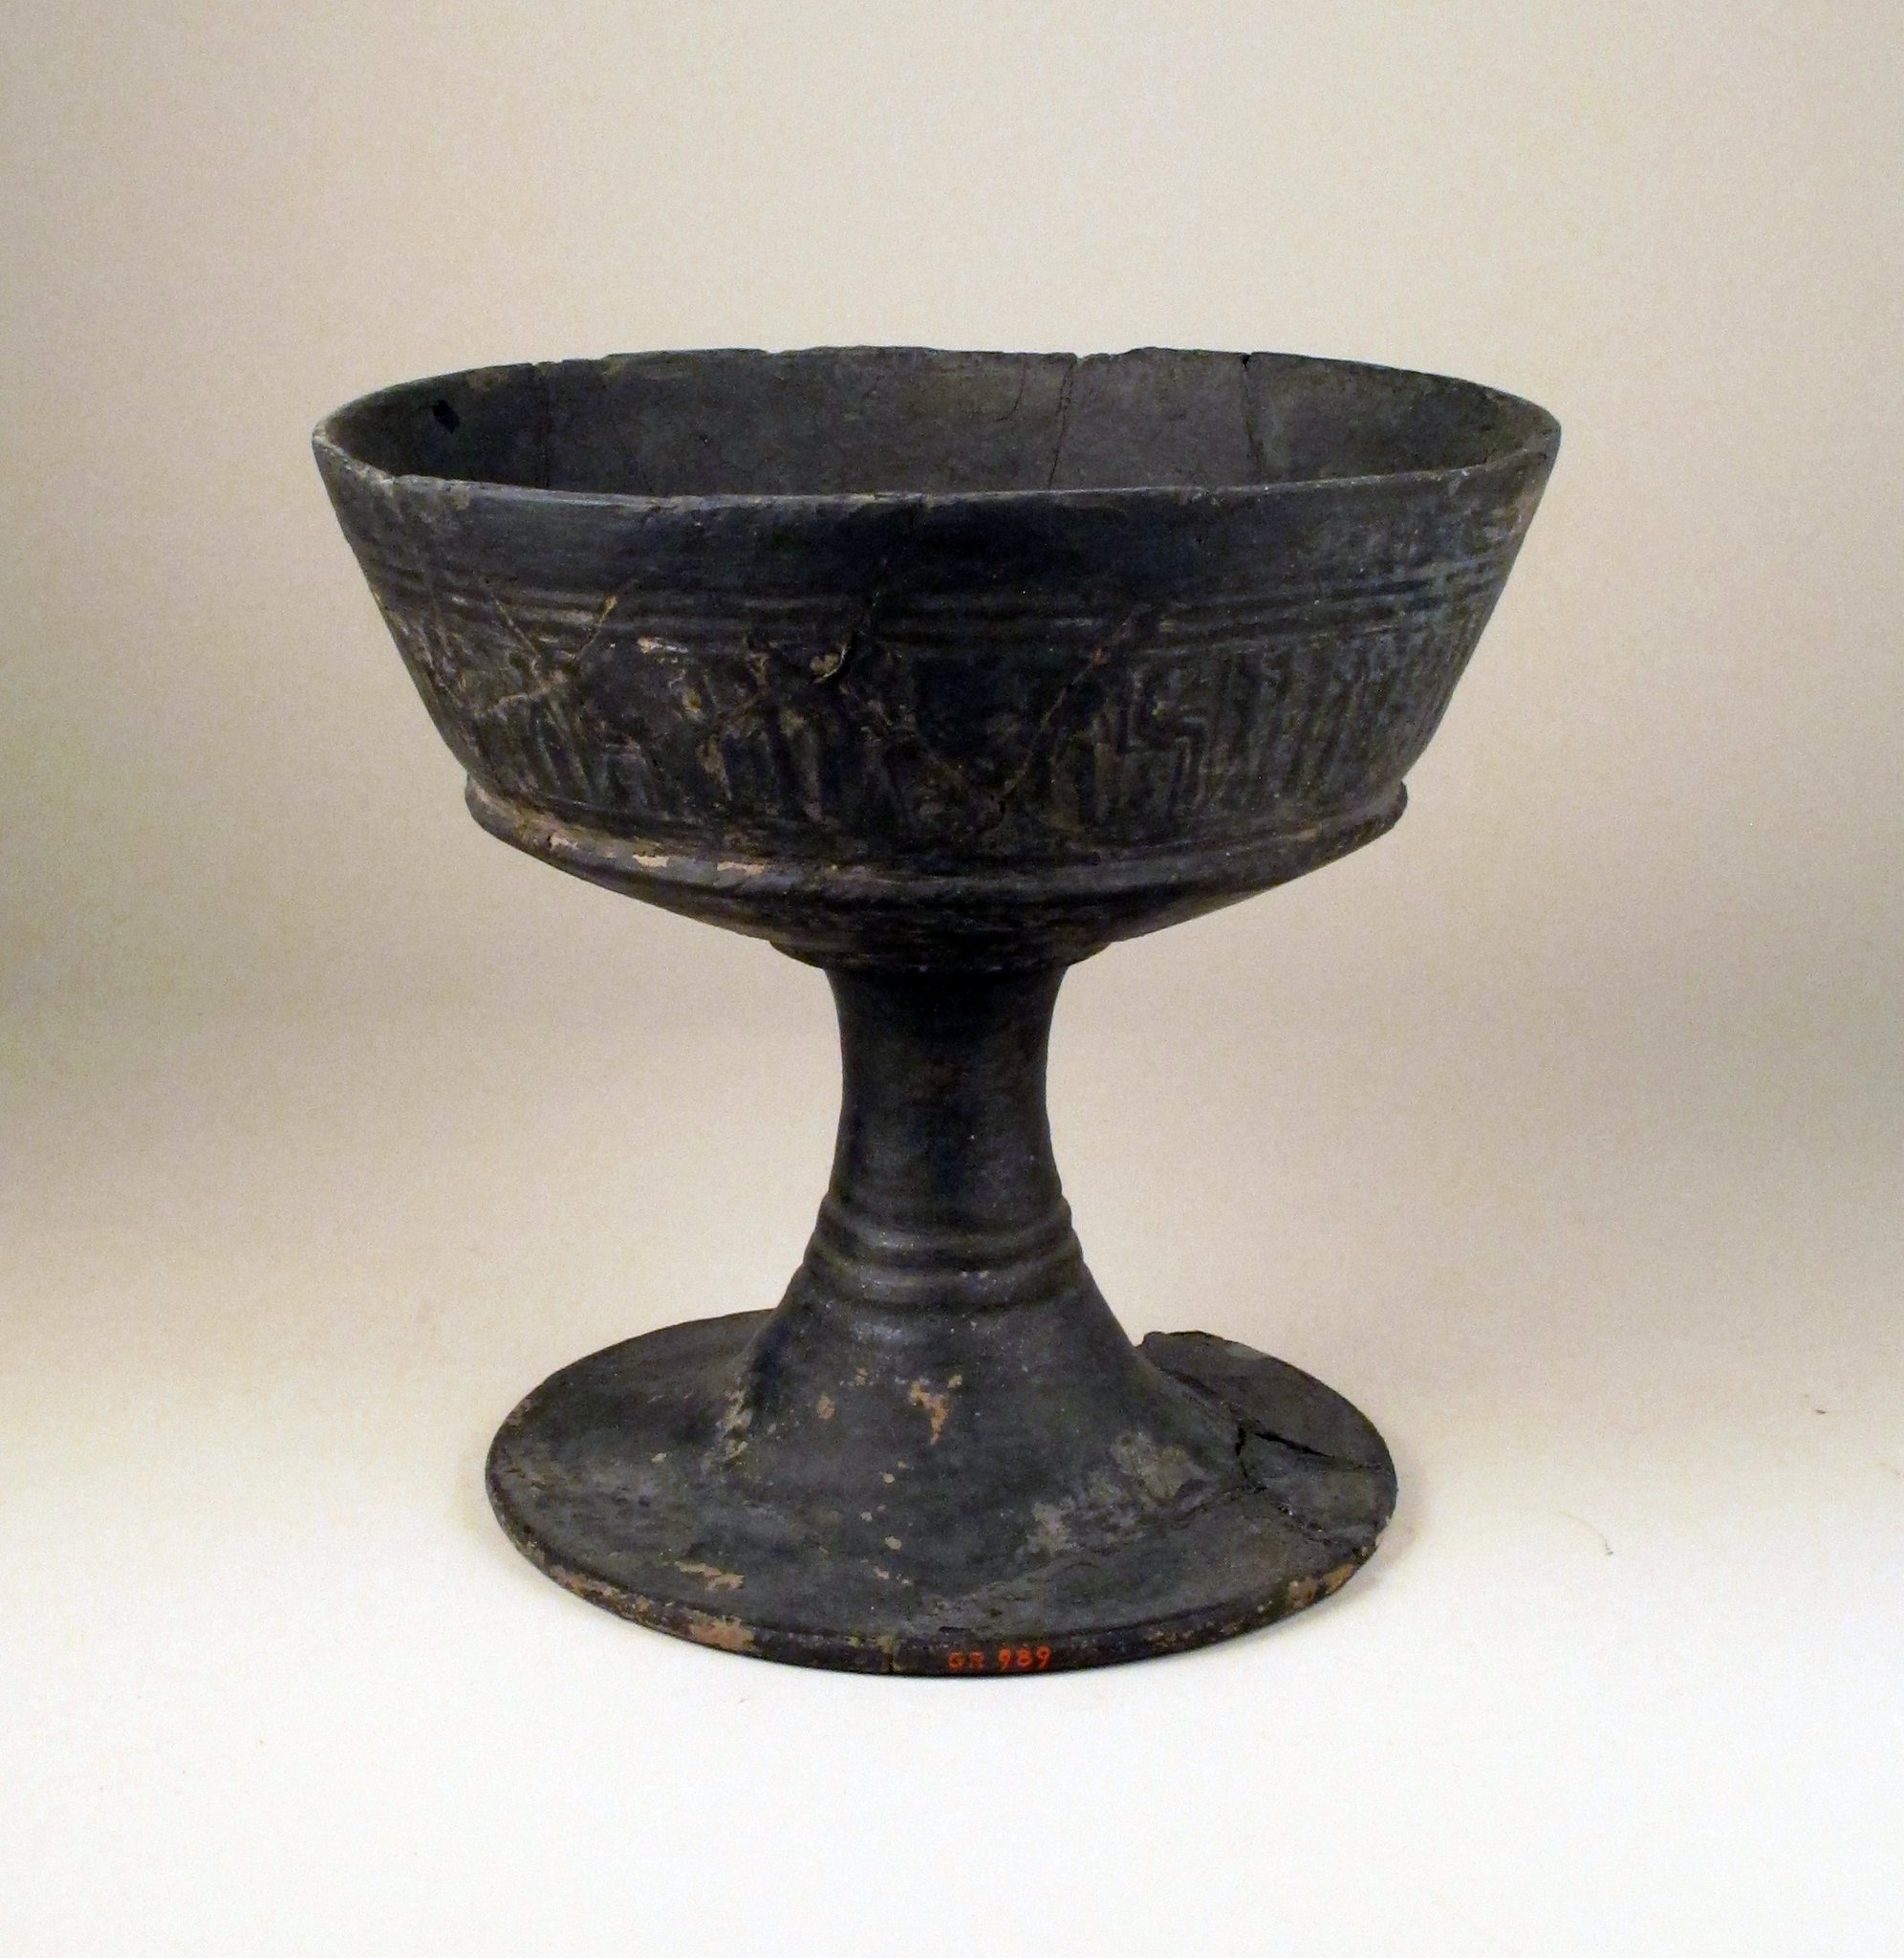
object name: cup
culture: etruscan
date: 570-560 BCE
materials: terracotta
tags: human figures